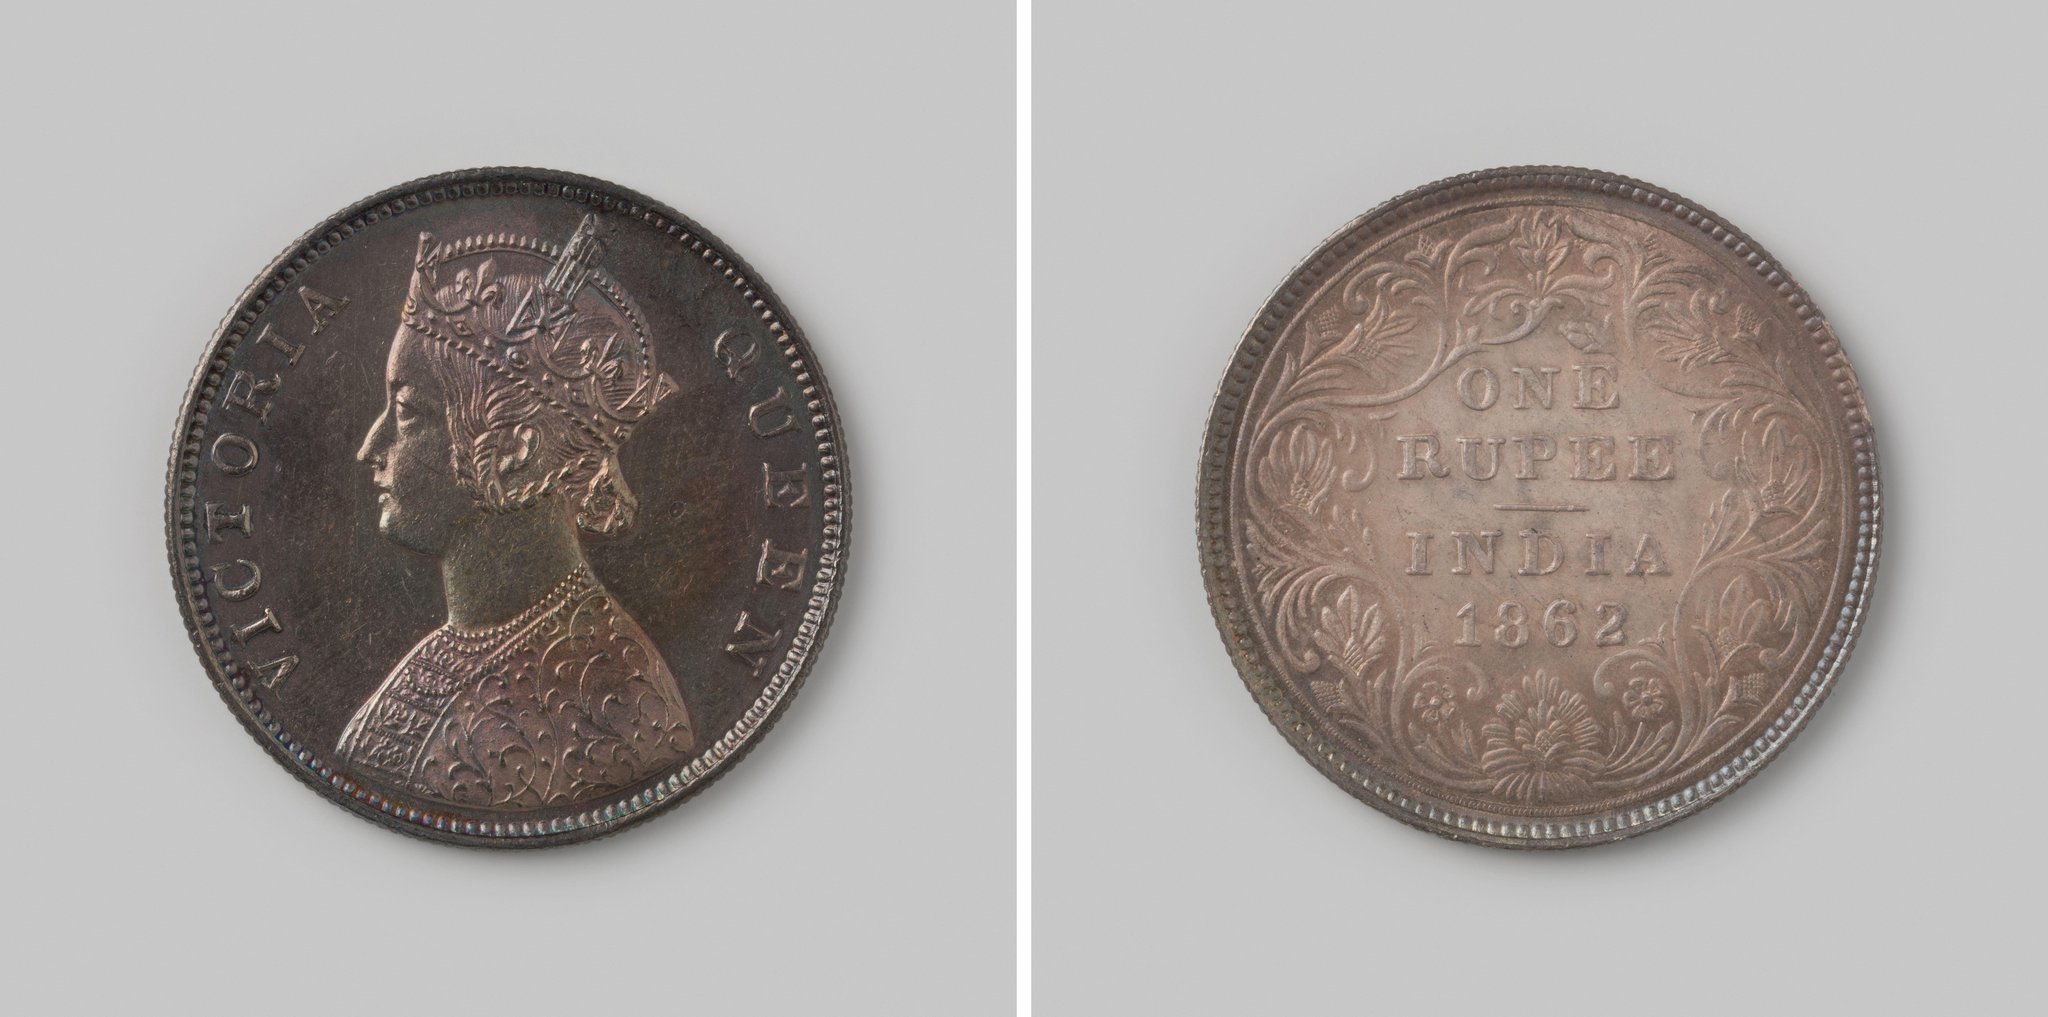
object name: coin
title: Roepie uit India van koningin Victoria, 1862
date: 1862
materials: silver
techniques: striking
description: Zilveren munt. Voorzijde: gekroond borstbeeld van koningin Victoria naar links. Keerzijde: binnen een kring van lotusbloemen in twee regels waarde-aanduiding: one rupee, waaronder lands-aanduiding. Daaronder jaartal. Kartelrand.